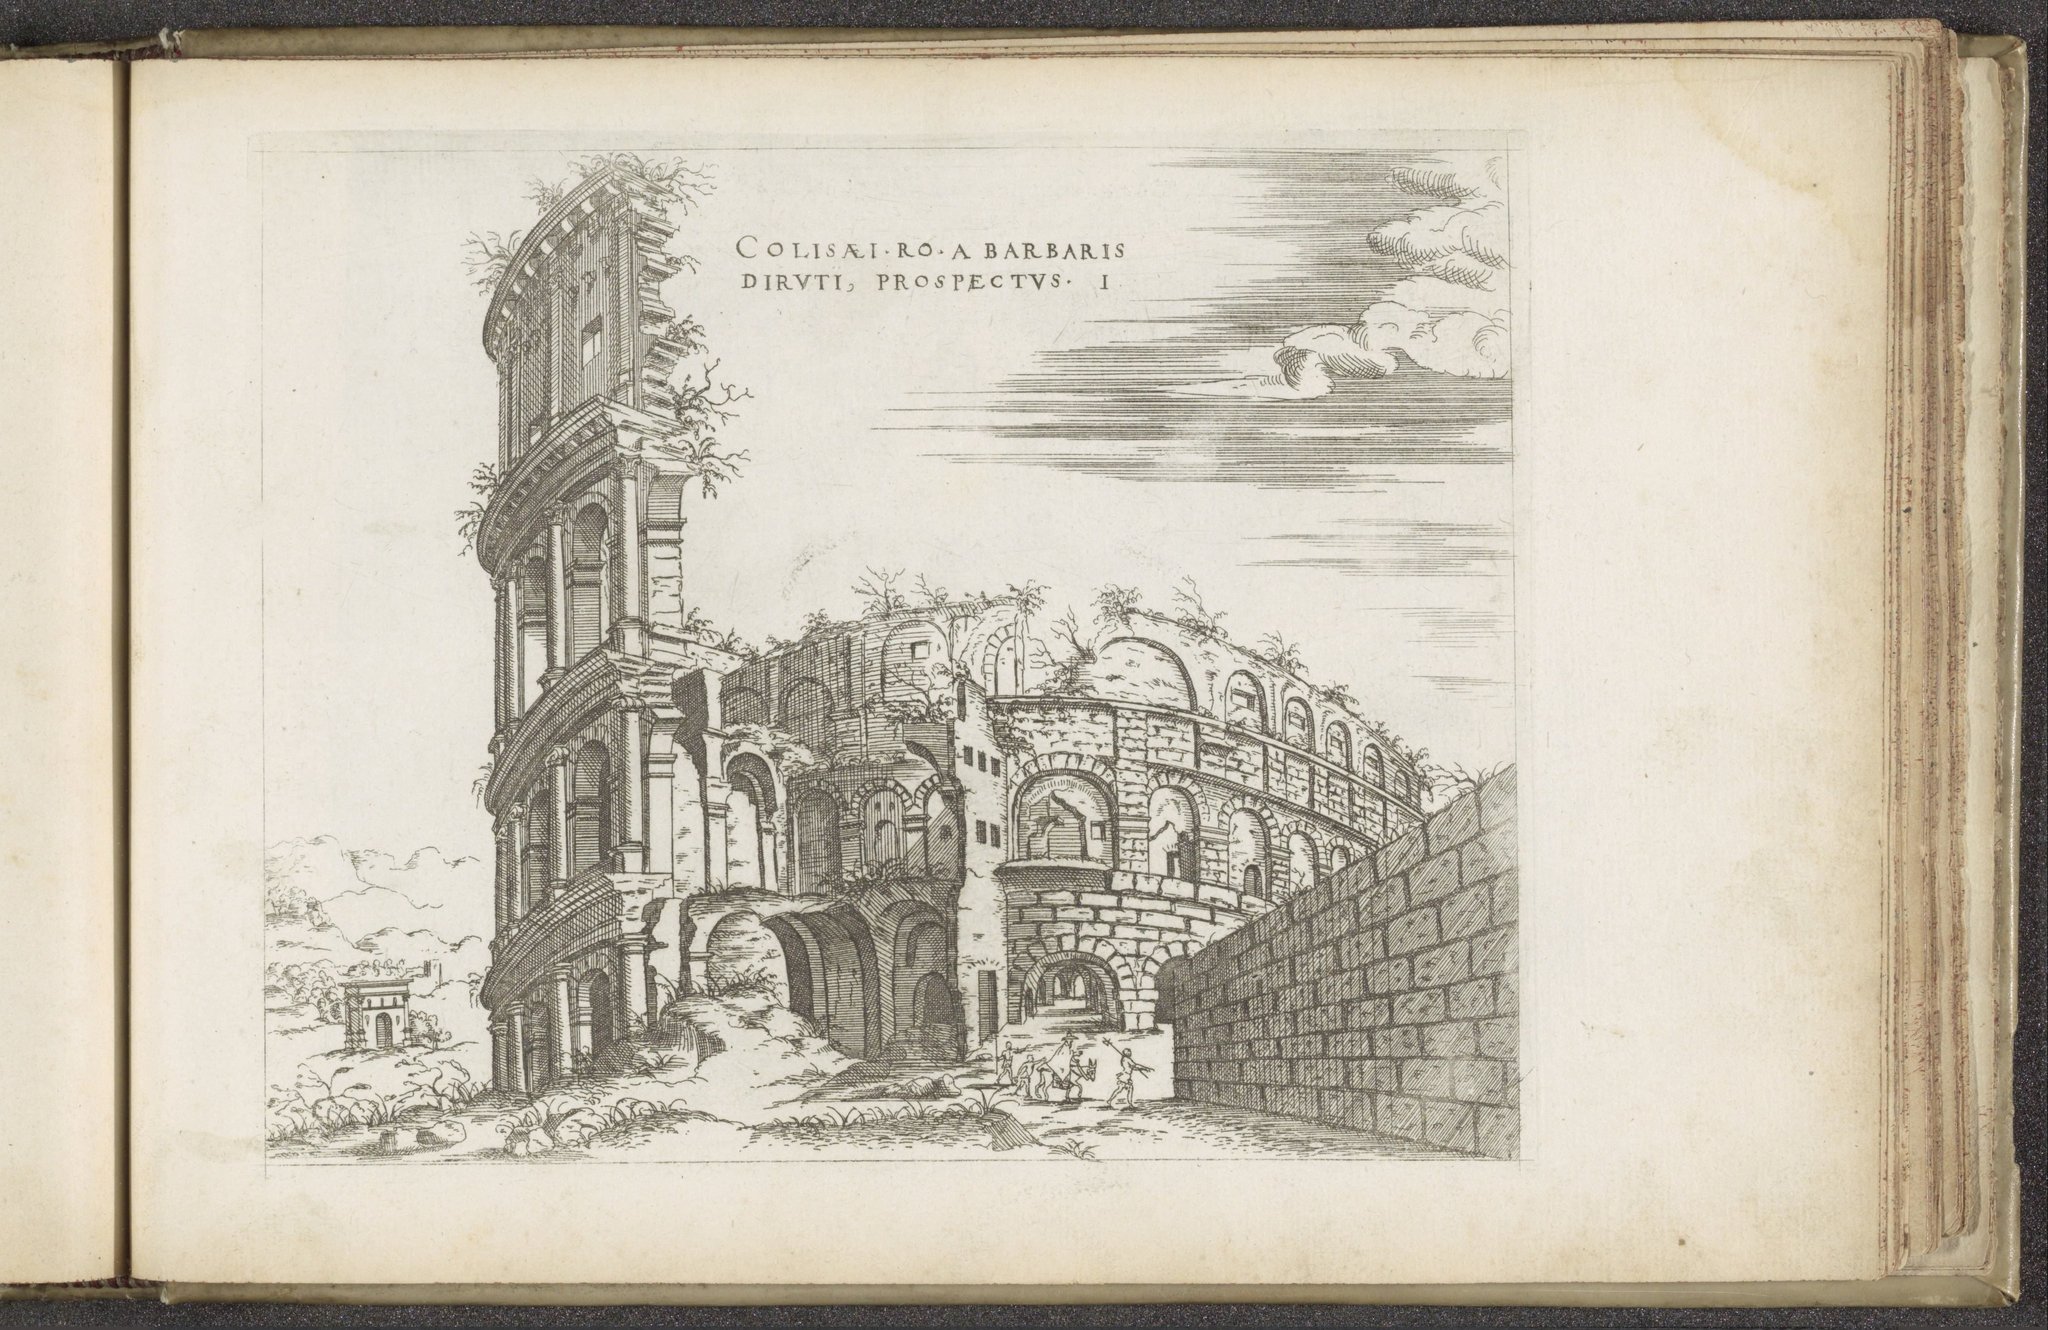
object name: album leaf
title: Eerste gezicht op het Colosseum te Rome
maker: jacques androuet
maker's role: draughtsman, print maker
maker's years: 1515-1584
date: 1551-1584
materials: paper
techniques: etching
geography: france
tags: ruin of a building ~ architecture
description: Gezicht op de ruïnes van het Colosseum in Rome. Bij een muur lopen drie mannen en een man rijdt op een paard. Deze prent maakt deel uit van een album.